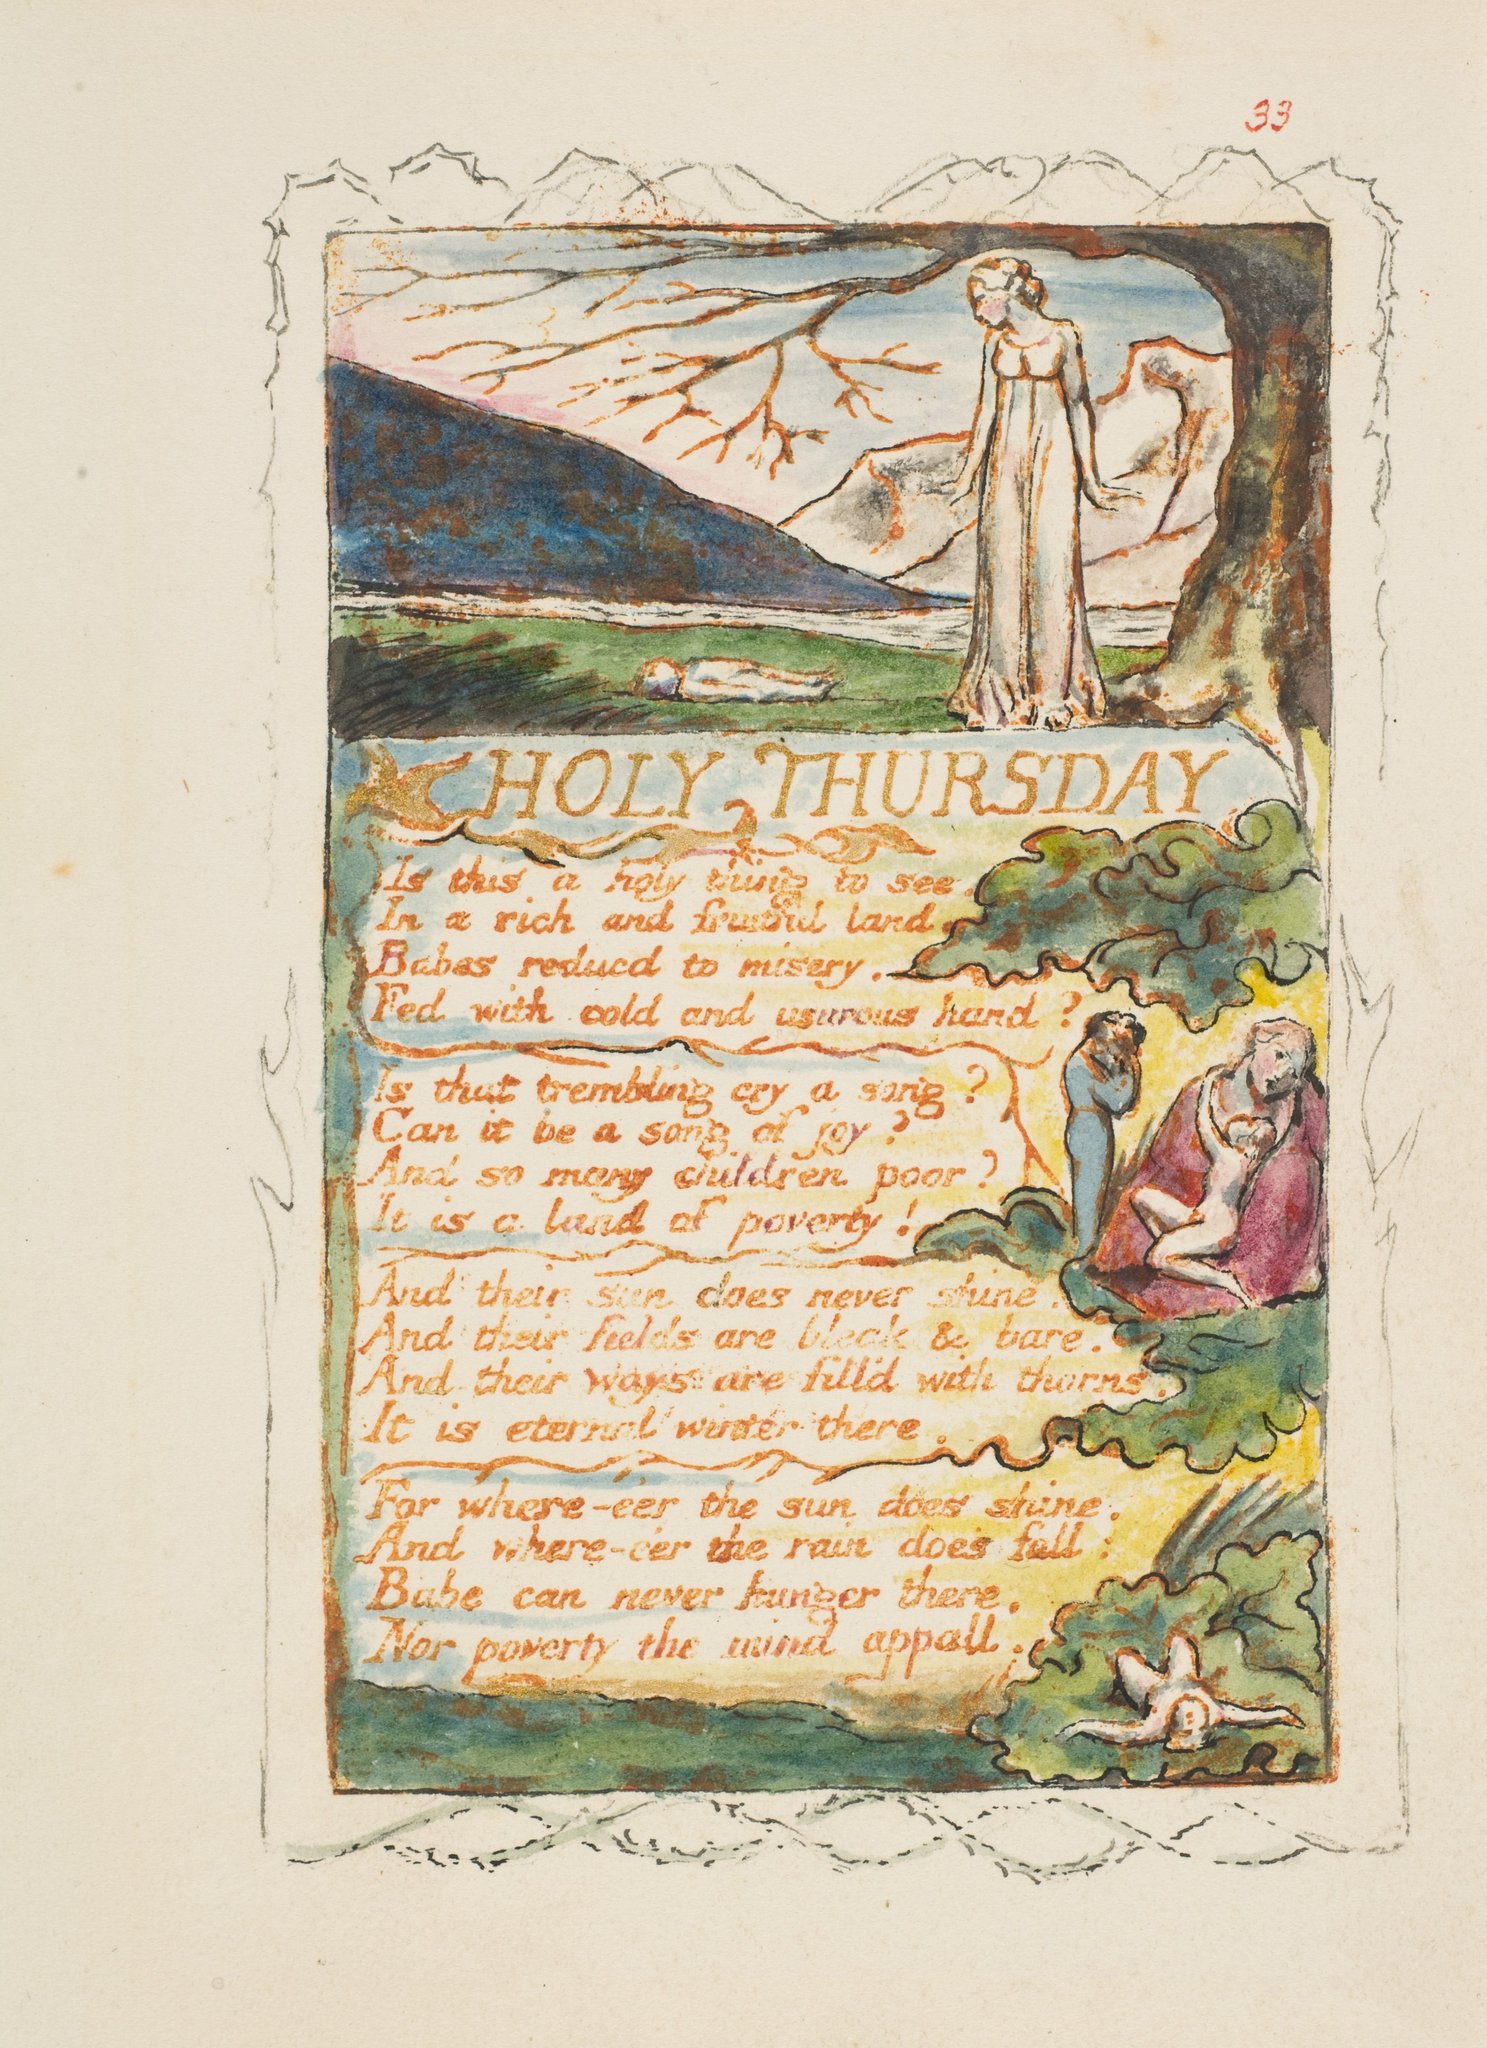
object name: print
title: Songs of Experience: Holy Thursday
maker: william blake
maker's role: artist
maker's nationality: british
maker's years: 1757-1827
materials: gold, ink, shell, watercolor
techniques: etching, hand coloring, printing, relief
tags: poetry,children,women